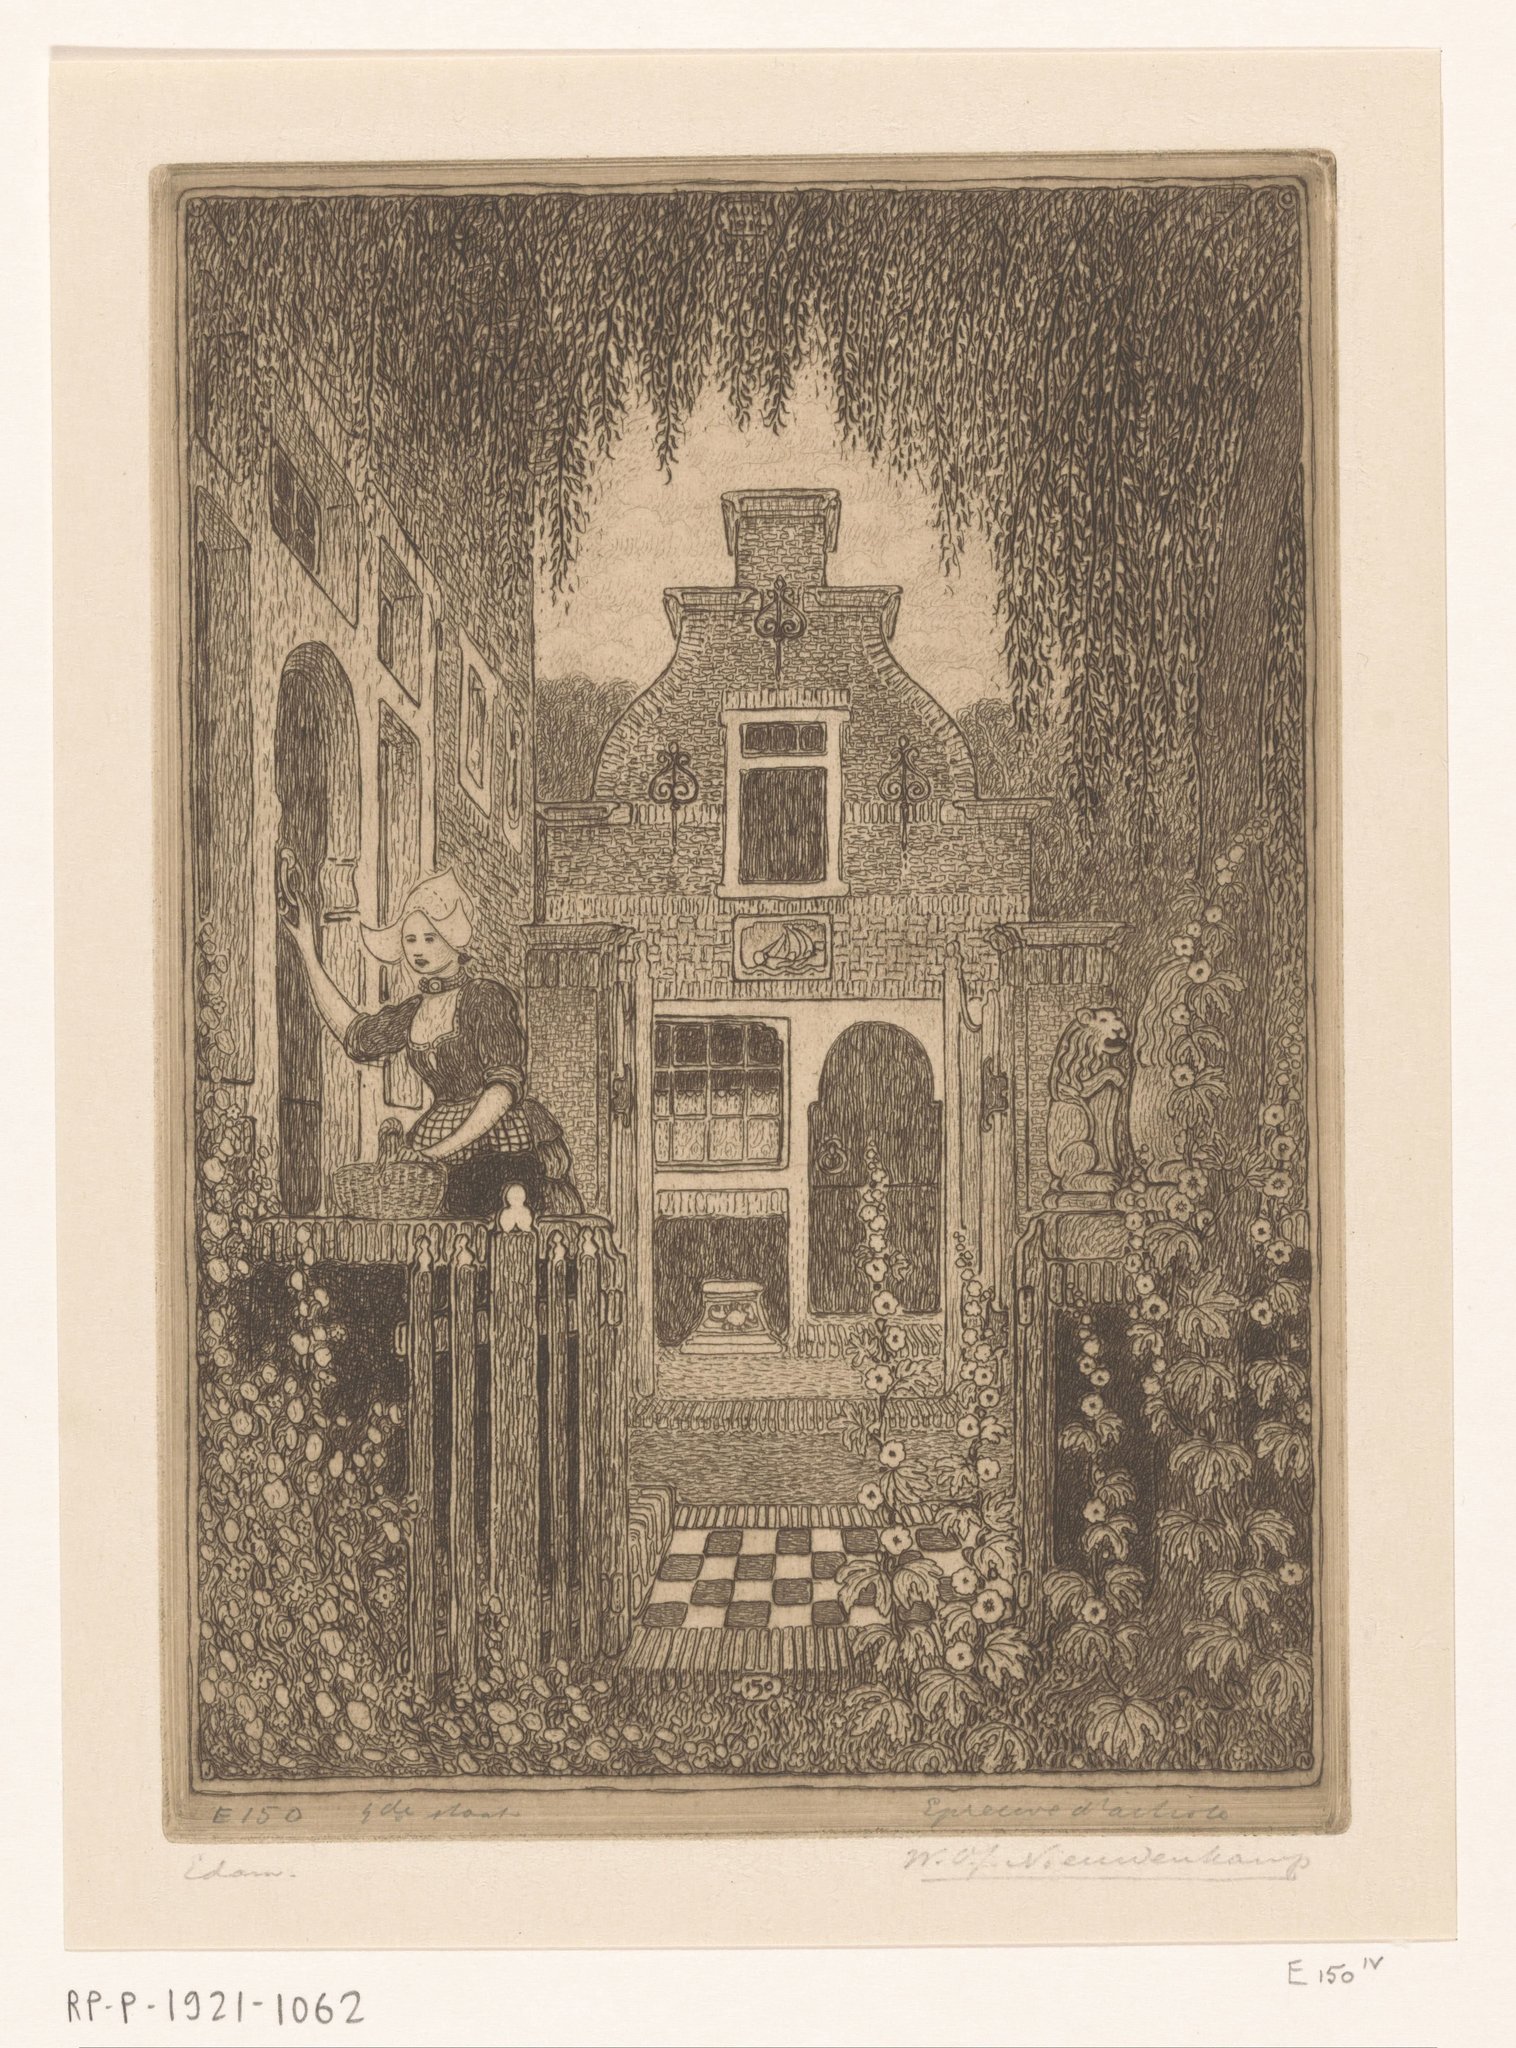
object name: print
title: Aan de voordeur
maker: wijnand otto jan nieuwenkamp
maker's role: draughtsman, print maker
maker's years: 1874-1950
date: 1914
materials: paper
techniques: etching, intaglio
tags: knocking at the door, folk costume, regional costume, statues, sculptures in garden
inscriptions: collector's mark: Lugt 2233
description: Een vrouw in klederdracht klopt op de voordeur van een woning in Edam. Ze heeft een mand bij zich. Op de voorgrond klimplanten en twee beelden van leeuwen op sokkels.